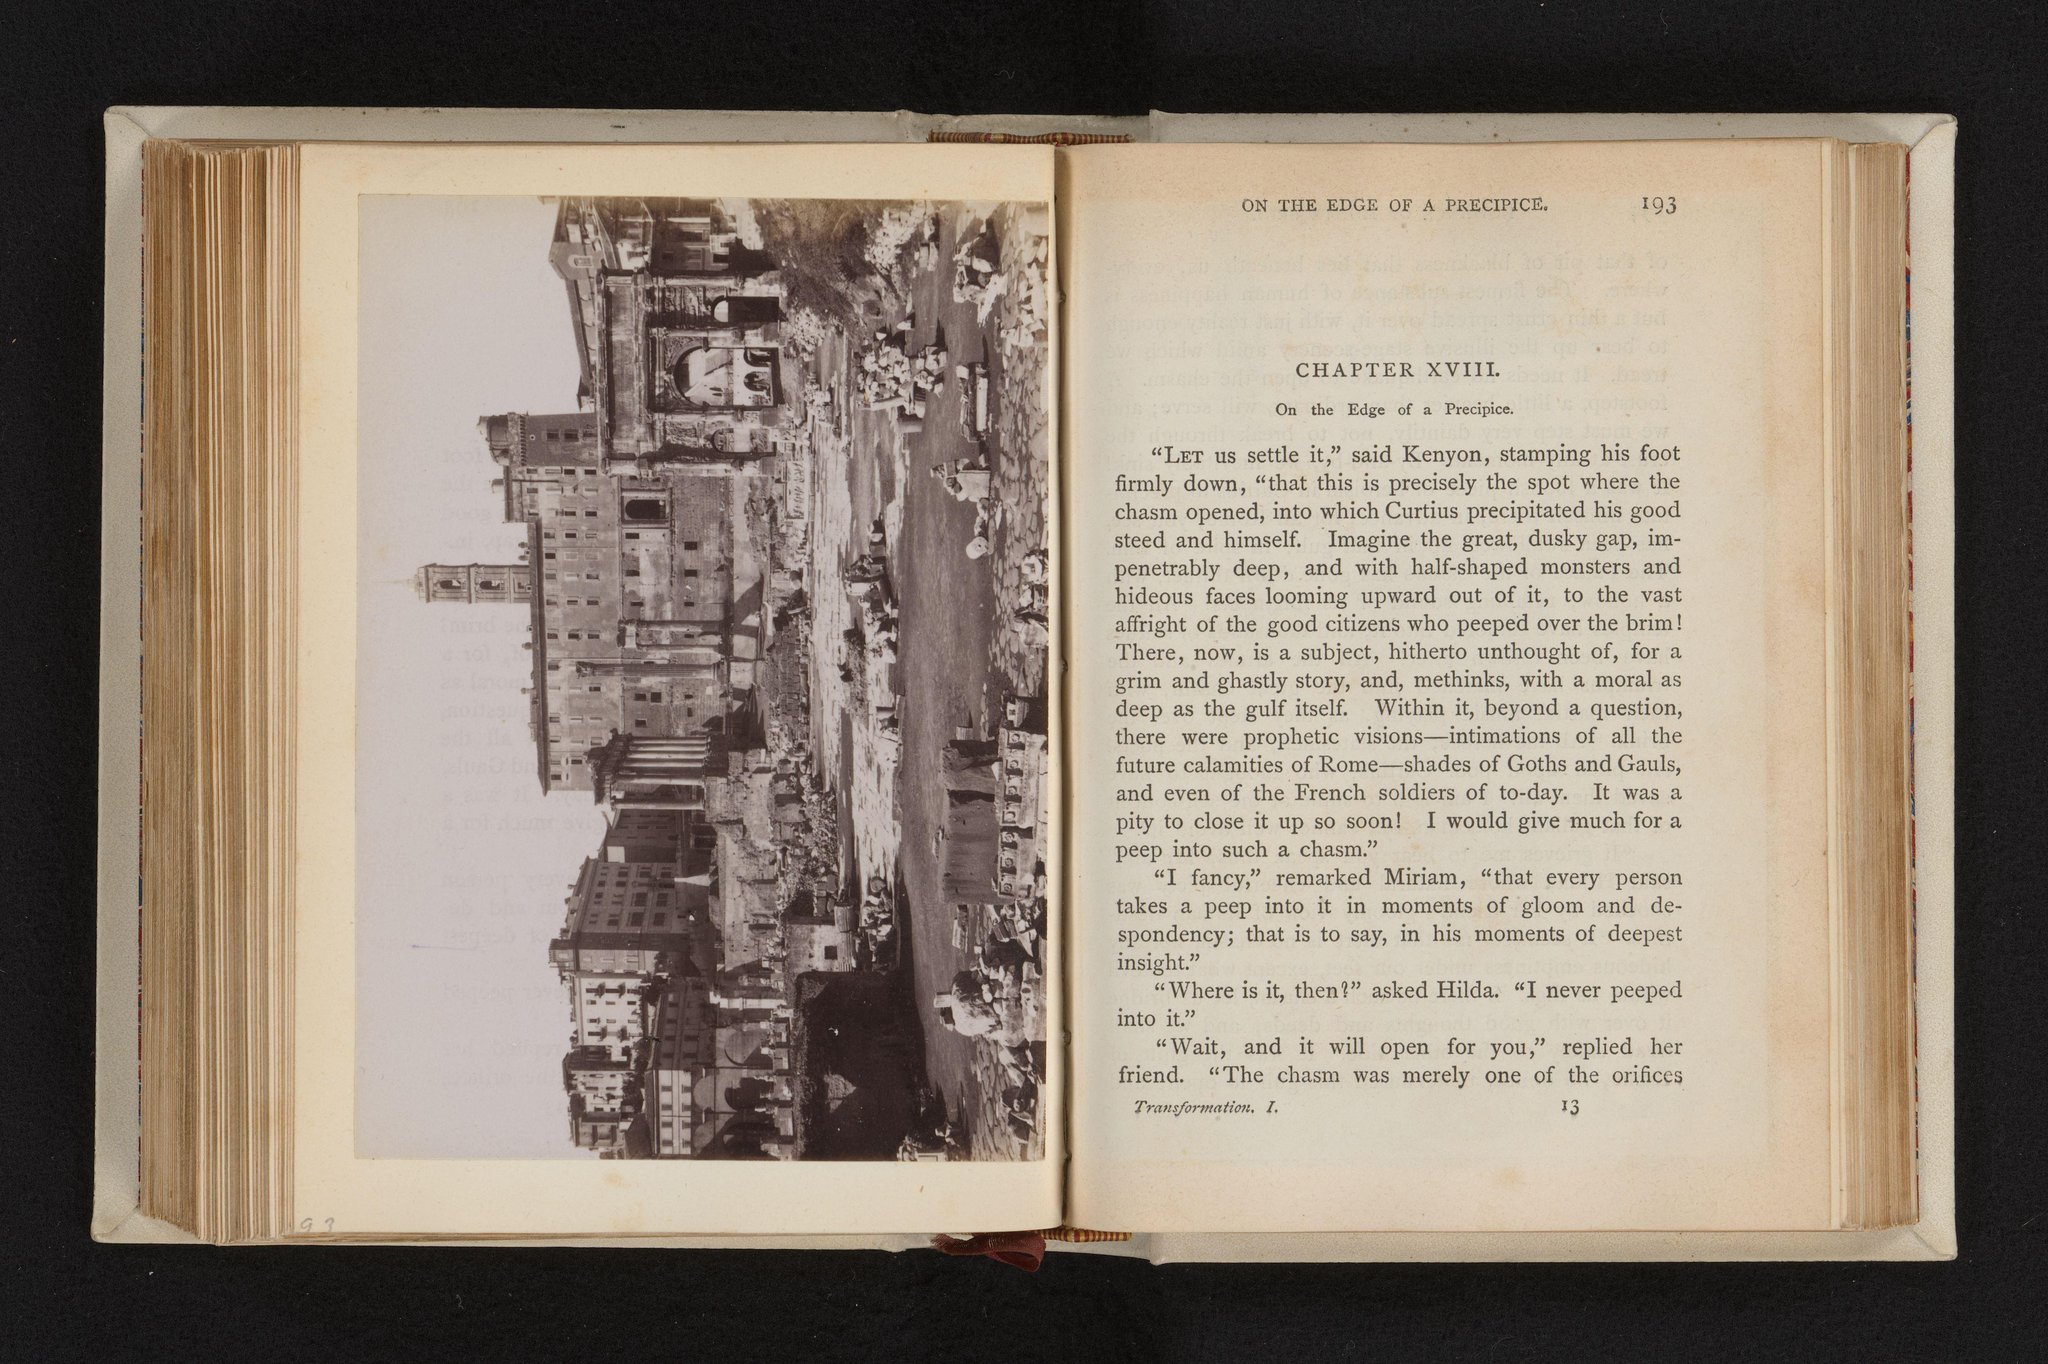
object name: photograph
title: Gezicht op het Forum Romanum in Rome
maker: Anonymous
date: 1850-1860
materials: photographic support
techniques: albumen print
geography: rome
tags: landscape with ruins